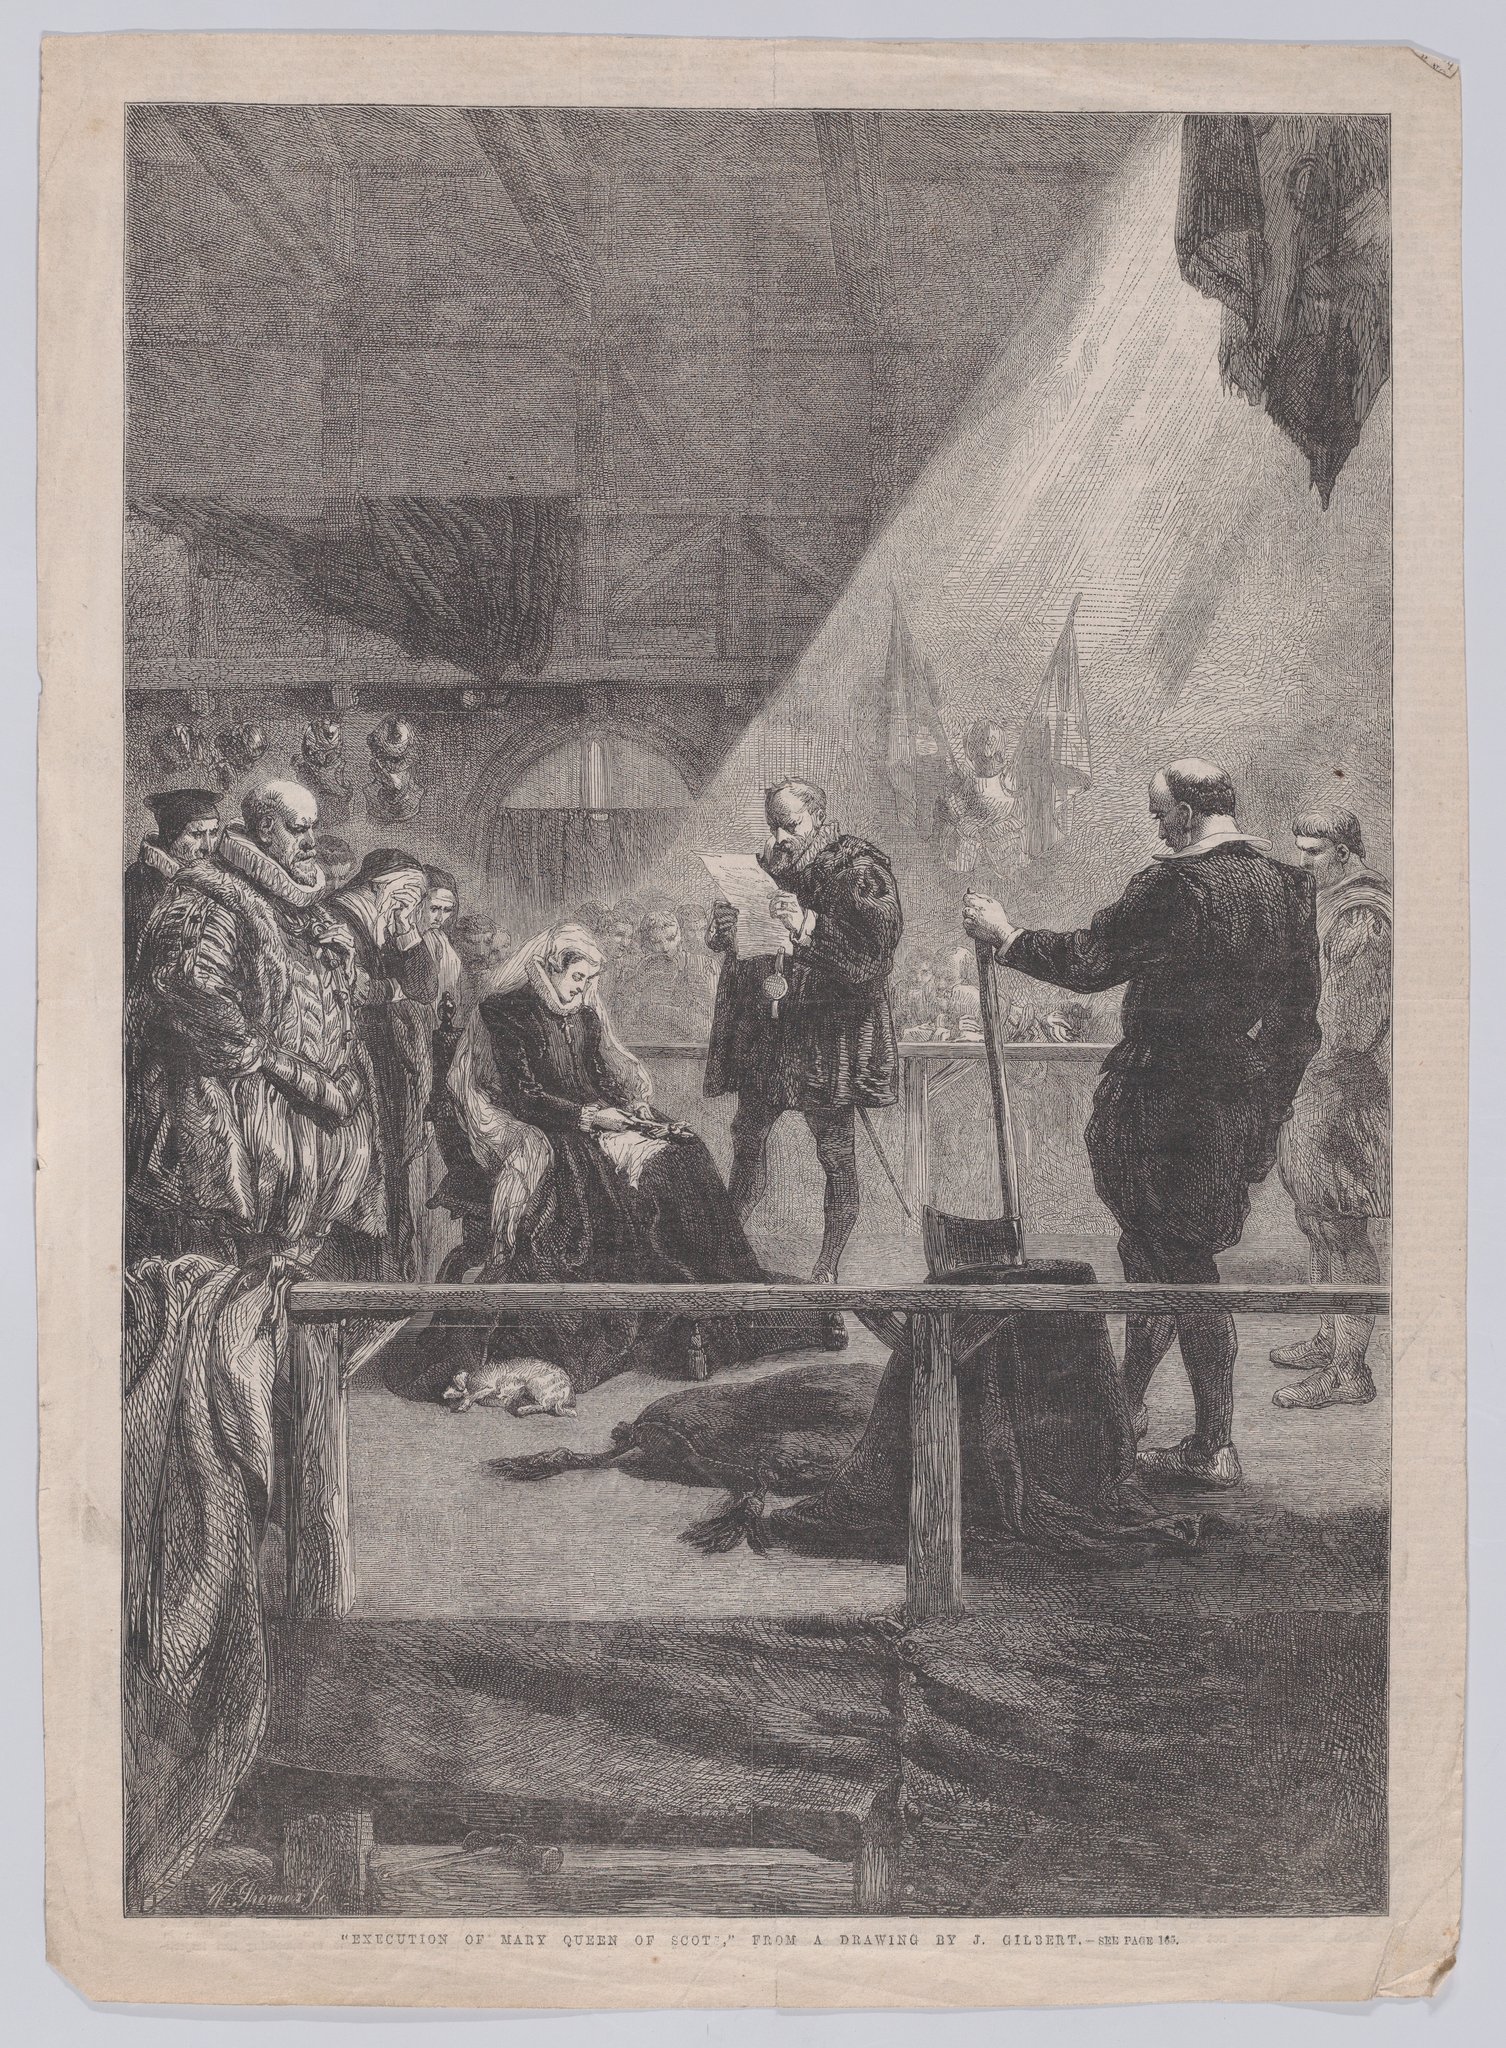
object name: print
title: Execution of Mary, Queen of Scots, from "Illustrated London News"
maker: william luson thomas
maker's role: engraver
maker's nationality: british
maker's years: 1830-1900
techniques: engraving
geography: england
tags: queens,men,women,dogs,execution,mary queen of scots